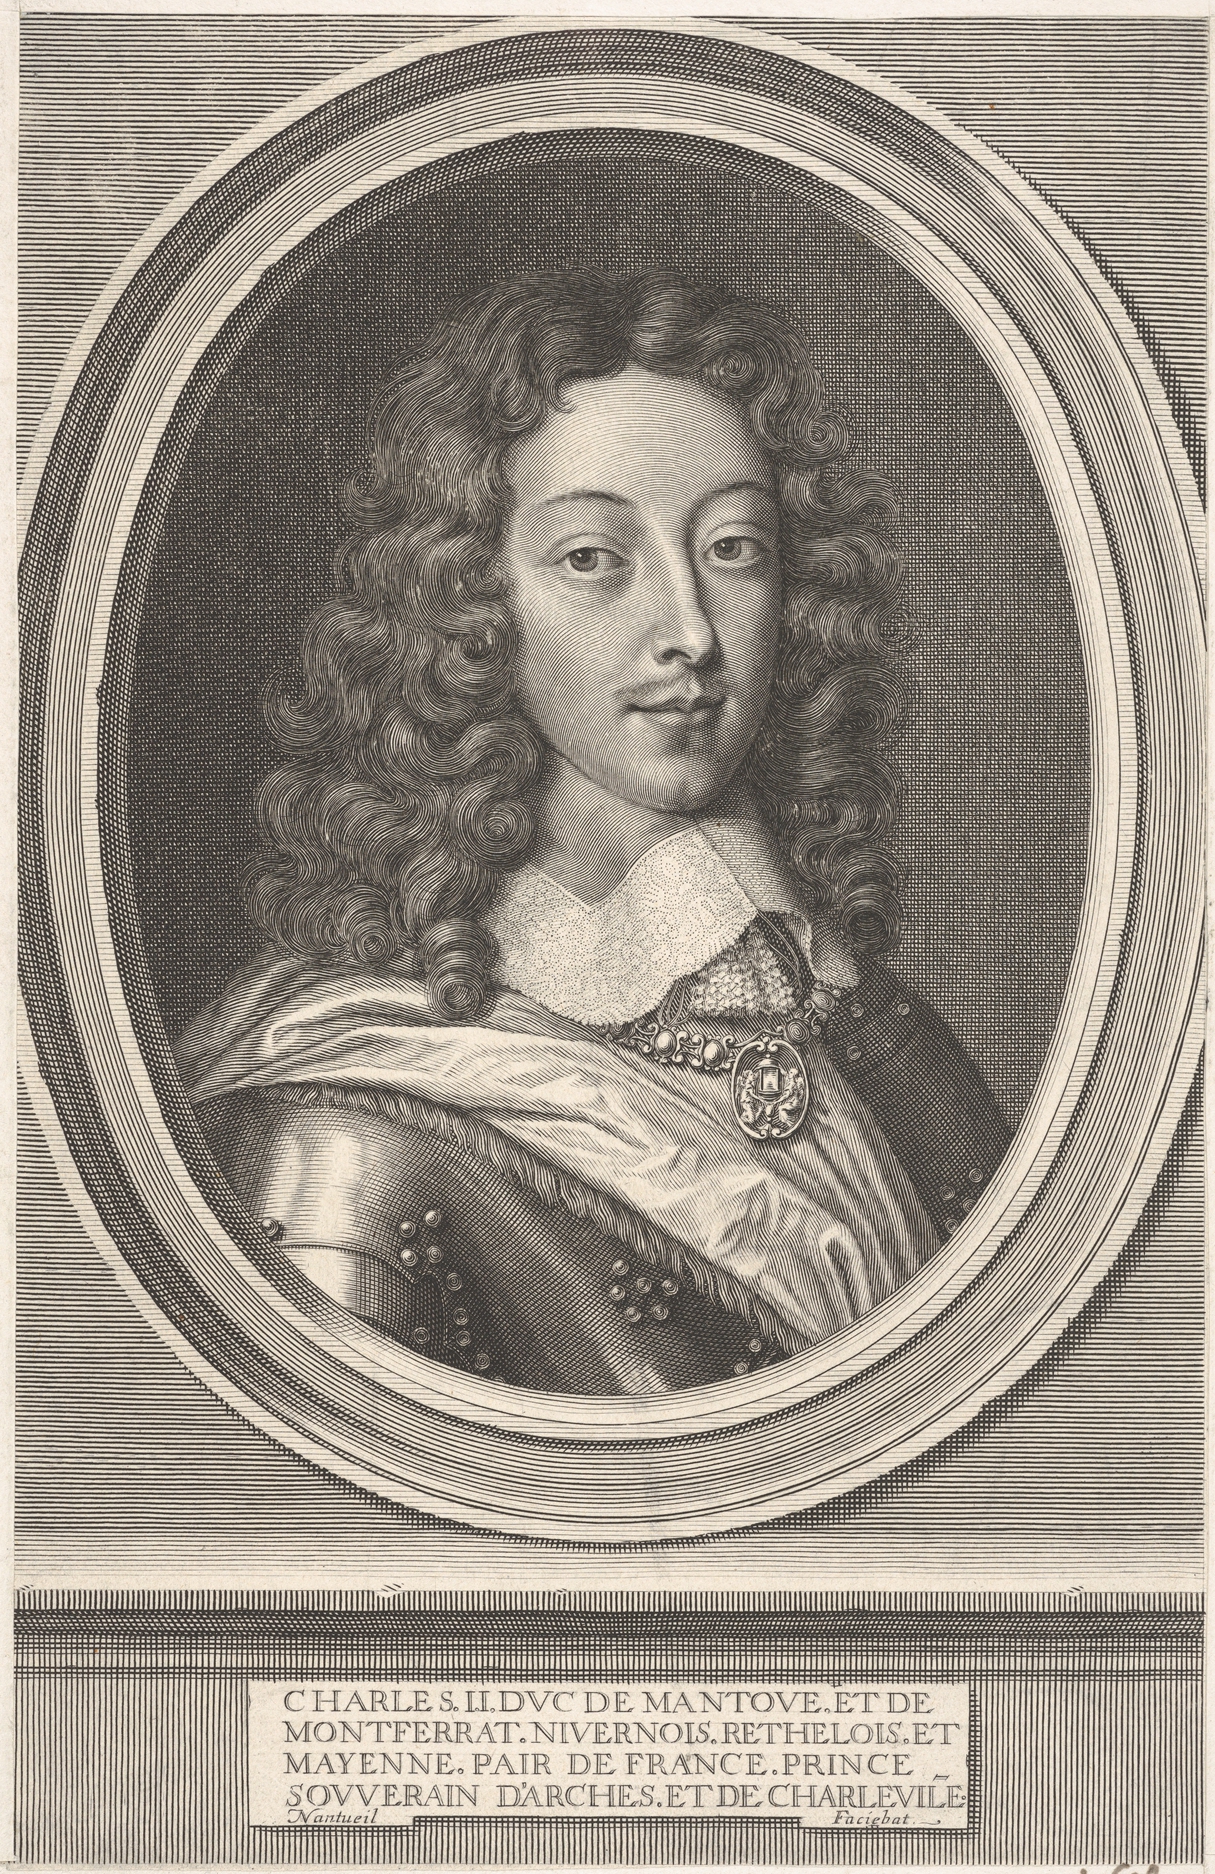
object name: print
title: Charles II de Gonzague-Clèves, duc de Mantoue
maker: robert nanteuil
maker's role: artist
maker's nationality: french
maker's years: 1623-1678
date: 1652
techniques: engraving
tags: men,portraits